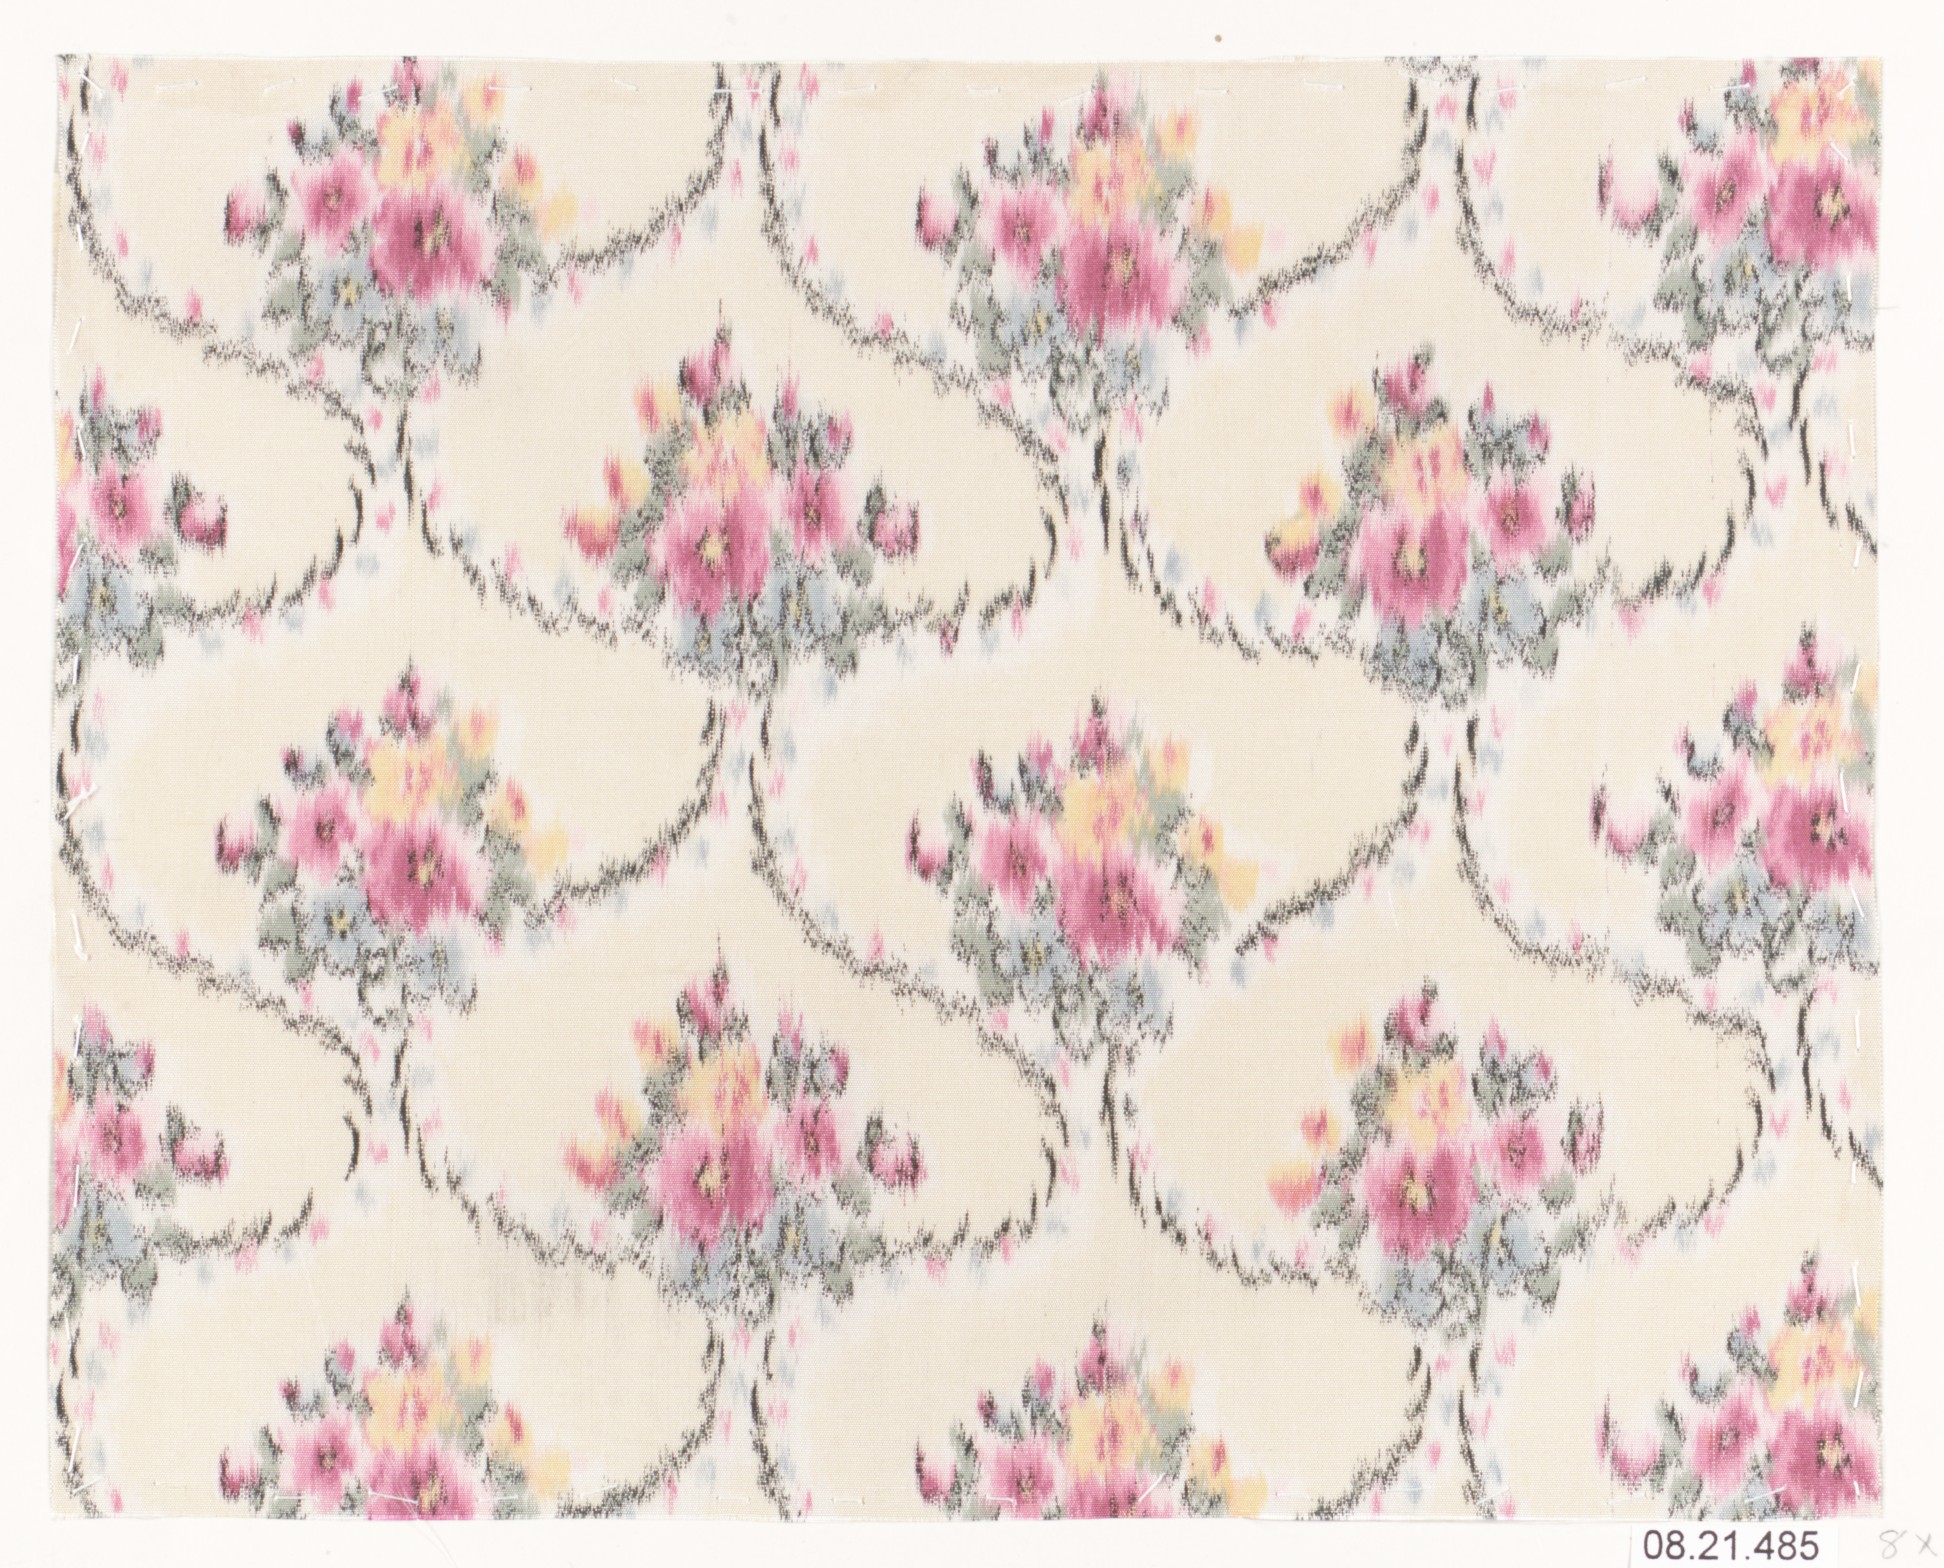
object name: textile sample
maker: Anonymous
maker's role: designer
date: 1900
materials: silk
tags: flowers